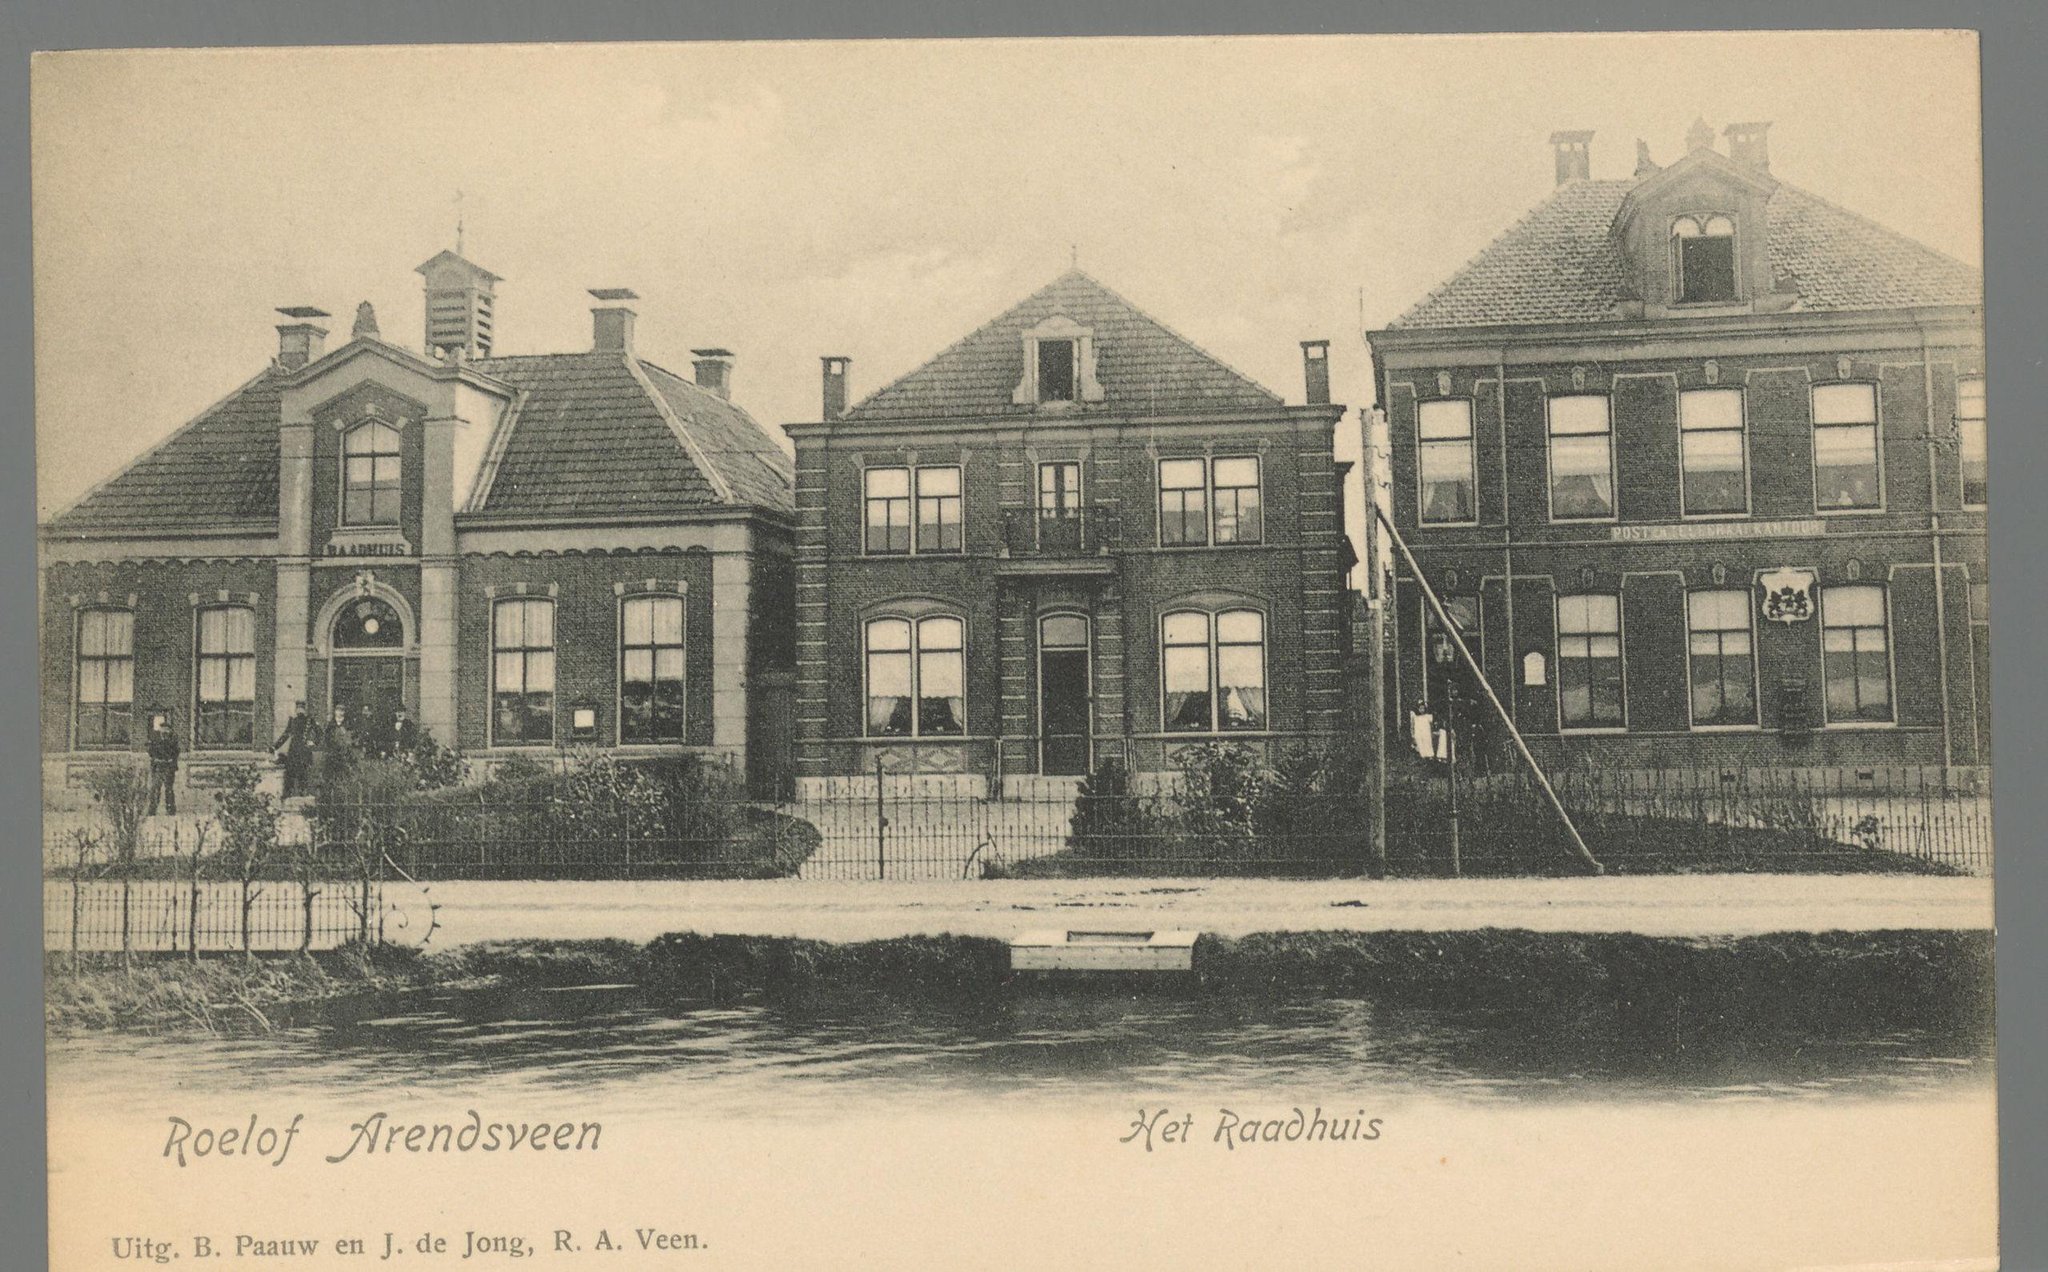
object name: ansichtkaart, prentbriefkaart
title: Roelof Arendsveen. Het Raadhuis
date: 1897-1905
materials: cardboard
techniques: photograph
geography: roelofarendsveen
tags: townhall, street